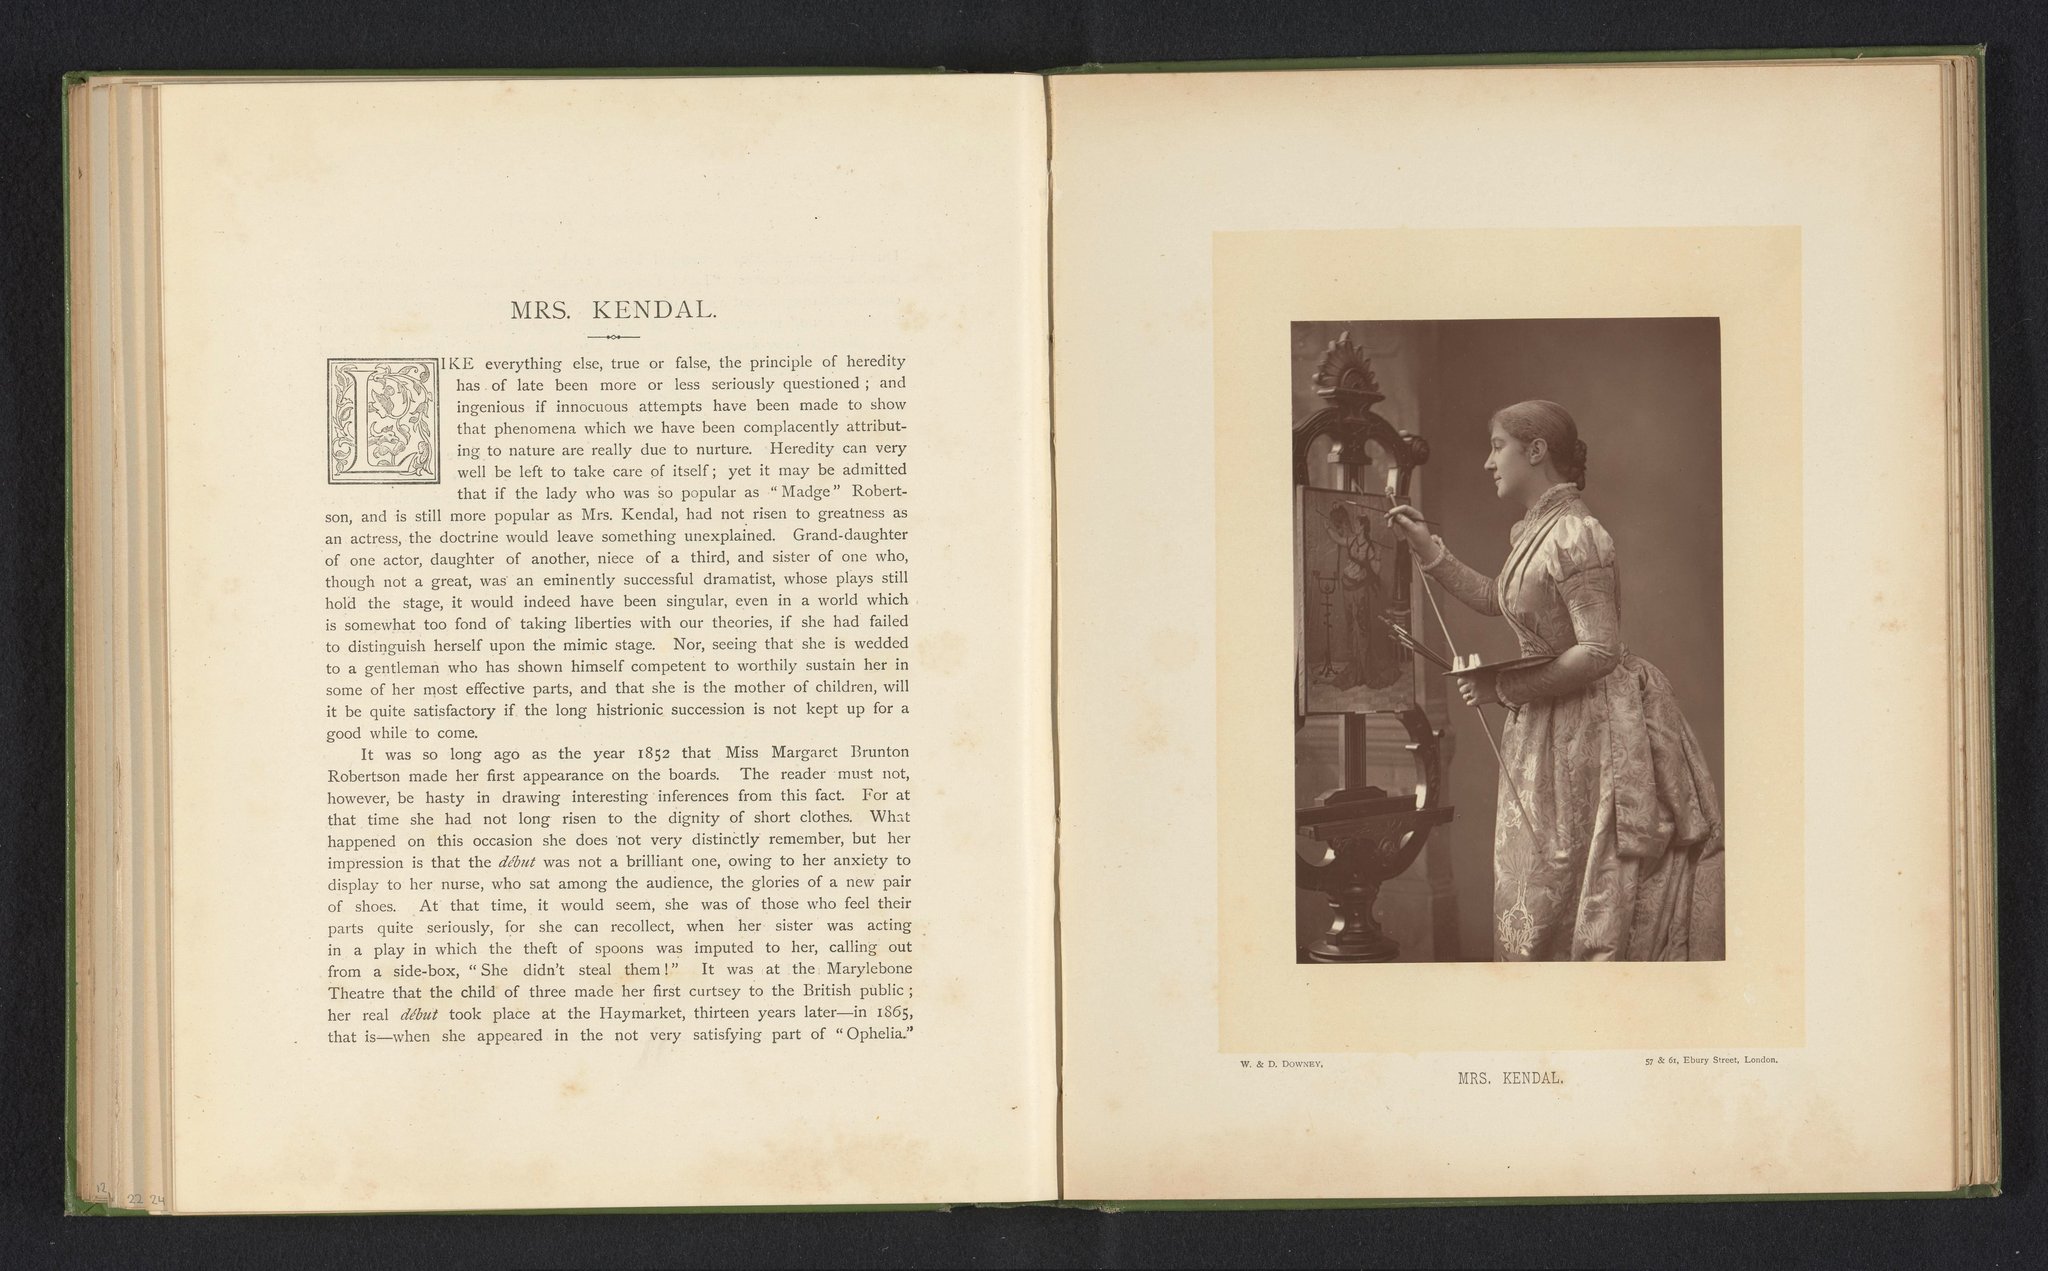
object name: photomechanical print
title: Mrs. Kendal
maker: Anonymous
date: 1884-1894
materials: paper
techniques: woodburytype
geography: london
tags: portrait of actor, actress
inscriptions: inscription: ‘57 & 61, Elbury Street, London.’